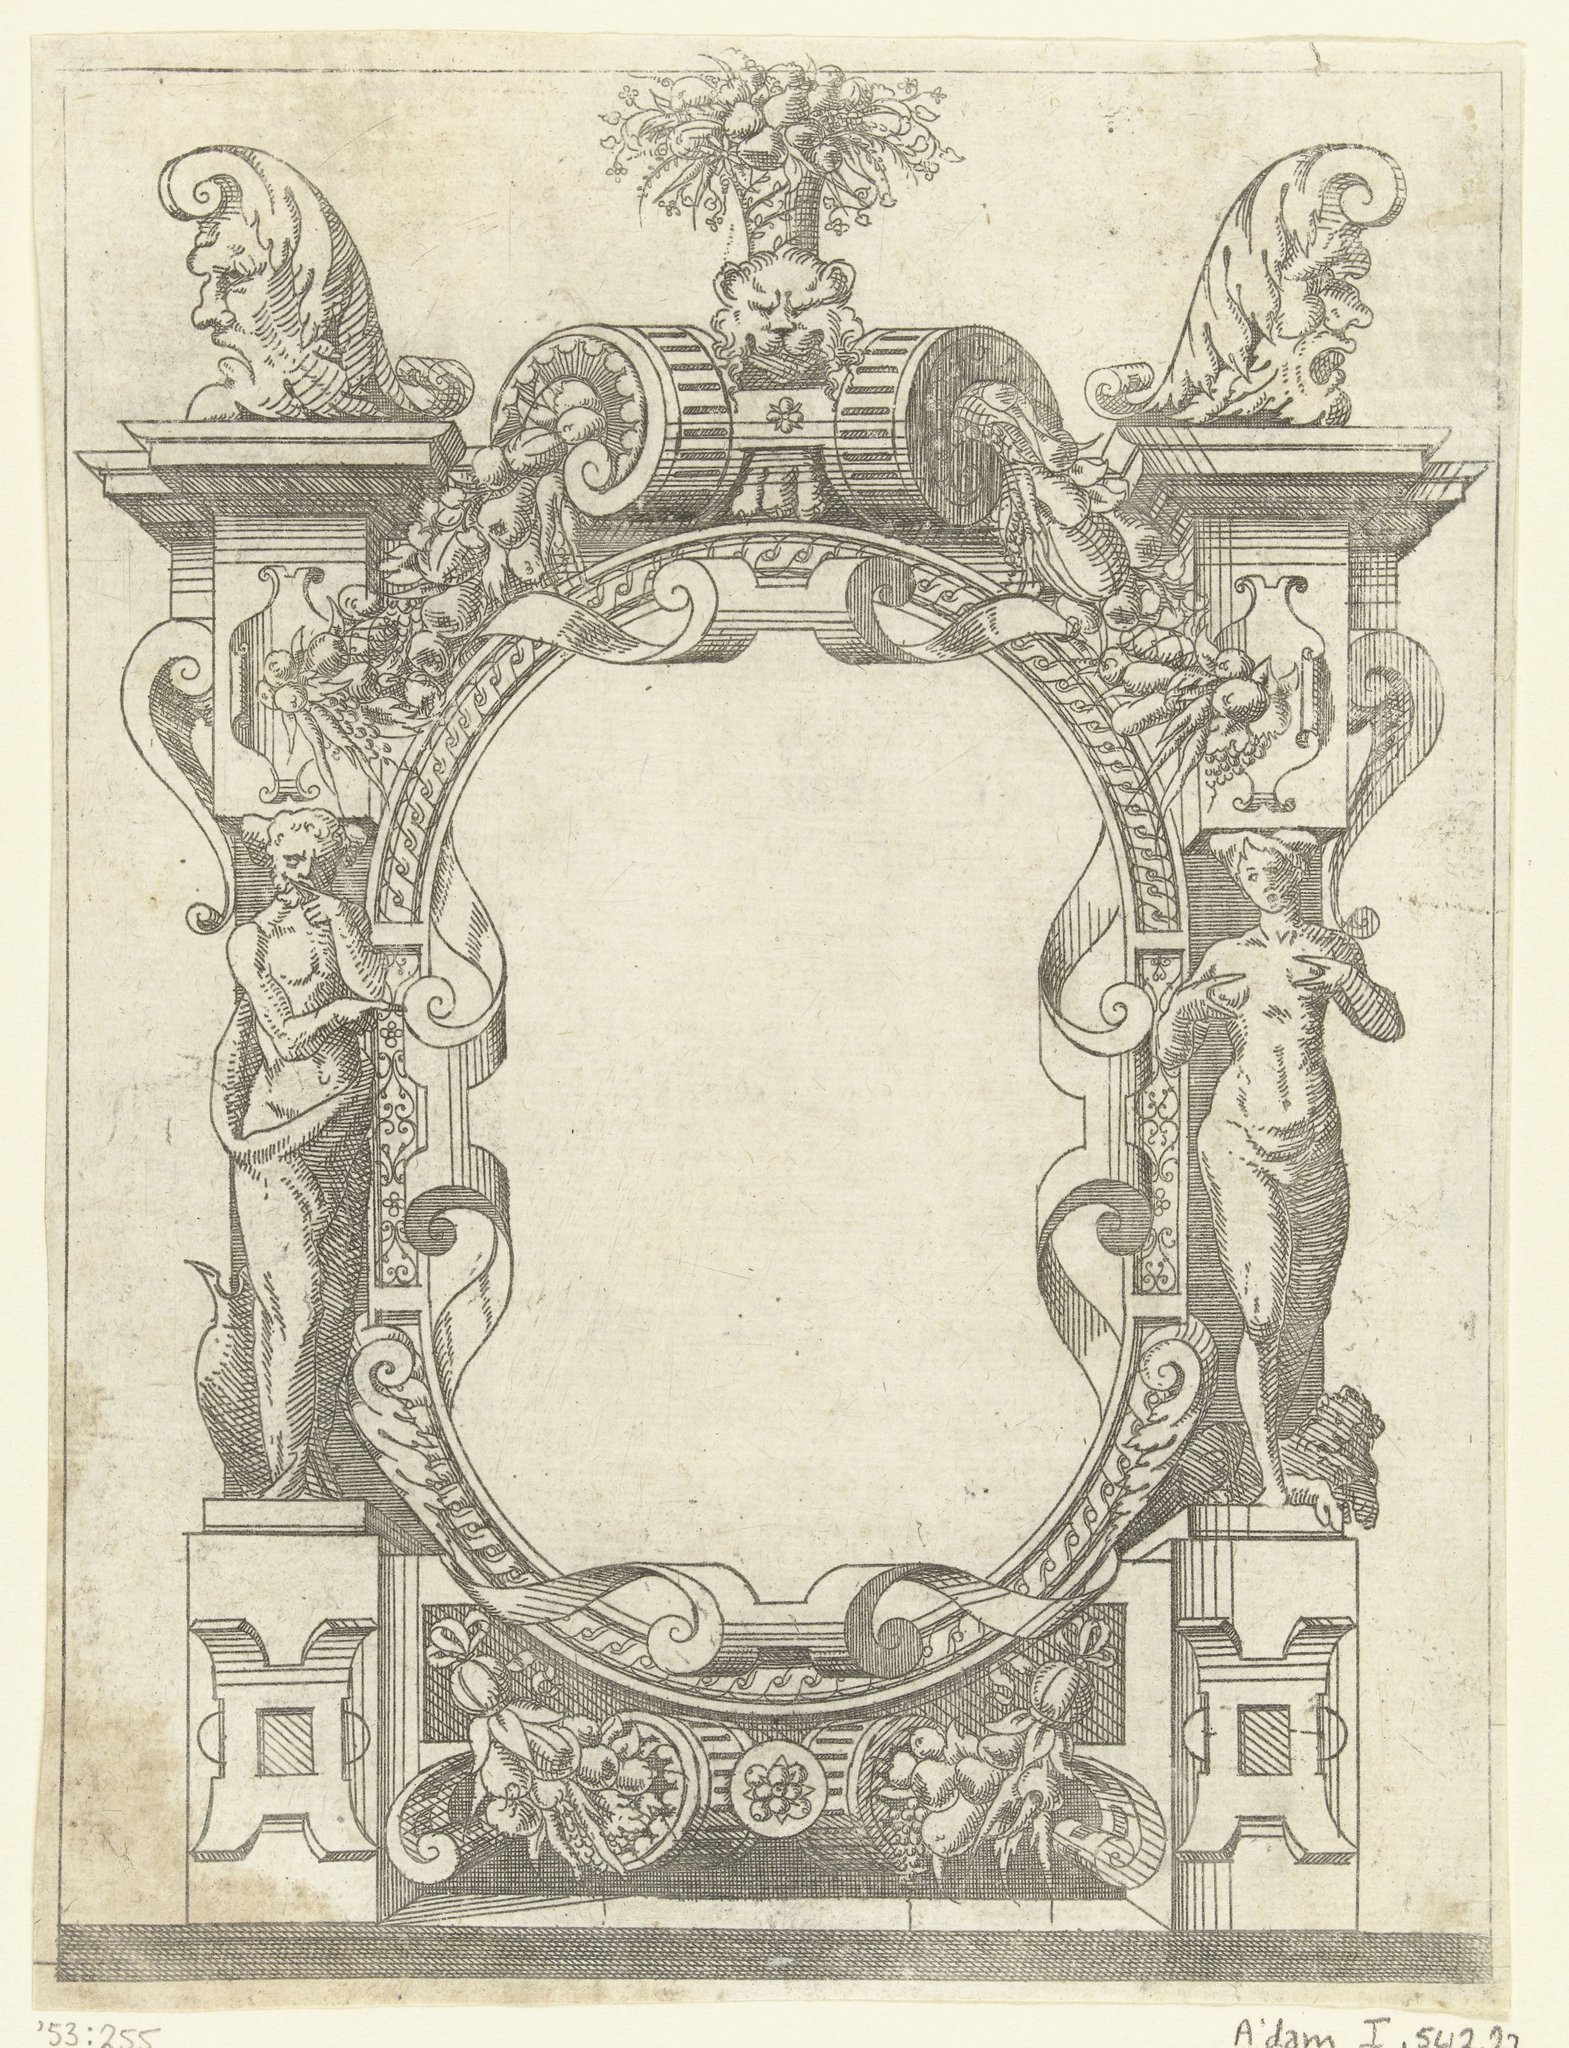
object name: print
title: Plafonds en cartouches in een omlijsting van rolwerk met grotesken, guirlandes en mascarons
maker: Anonymous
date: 1520-1584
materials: paper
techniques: etching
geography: italy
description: Links staat een man met een vaas, rechts een vrouw met een leeuw aan haar voeten. Uit serie van 32 bladen. De cartouches zijn deels ontleend aan de prenten van Antonio Fantuzzi naar de decoratie van de Galerie van François 1er door Giovanni Battista Rosso. De serie staat ook bekend onder de titel Petits cartouches de Fontainebleau.